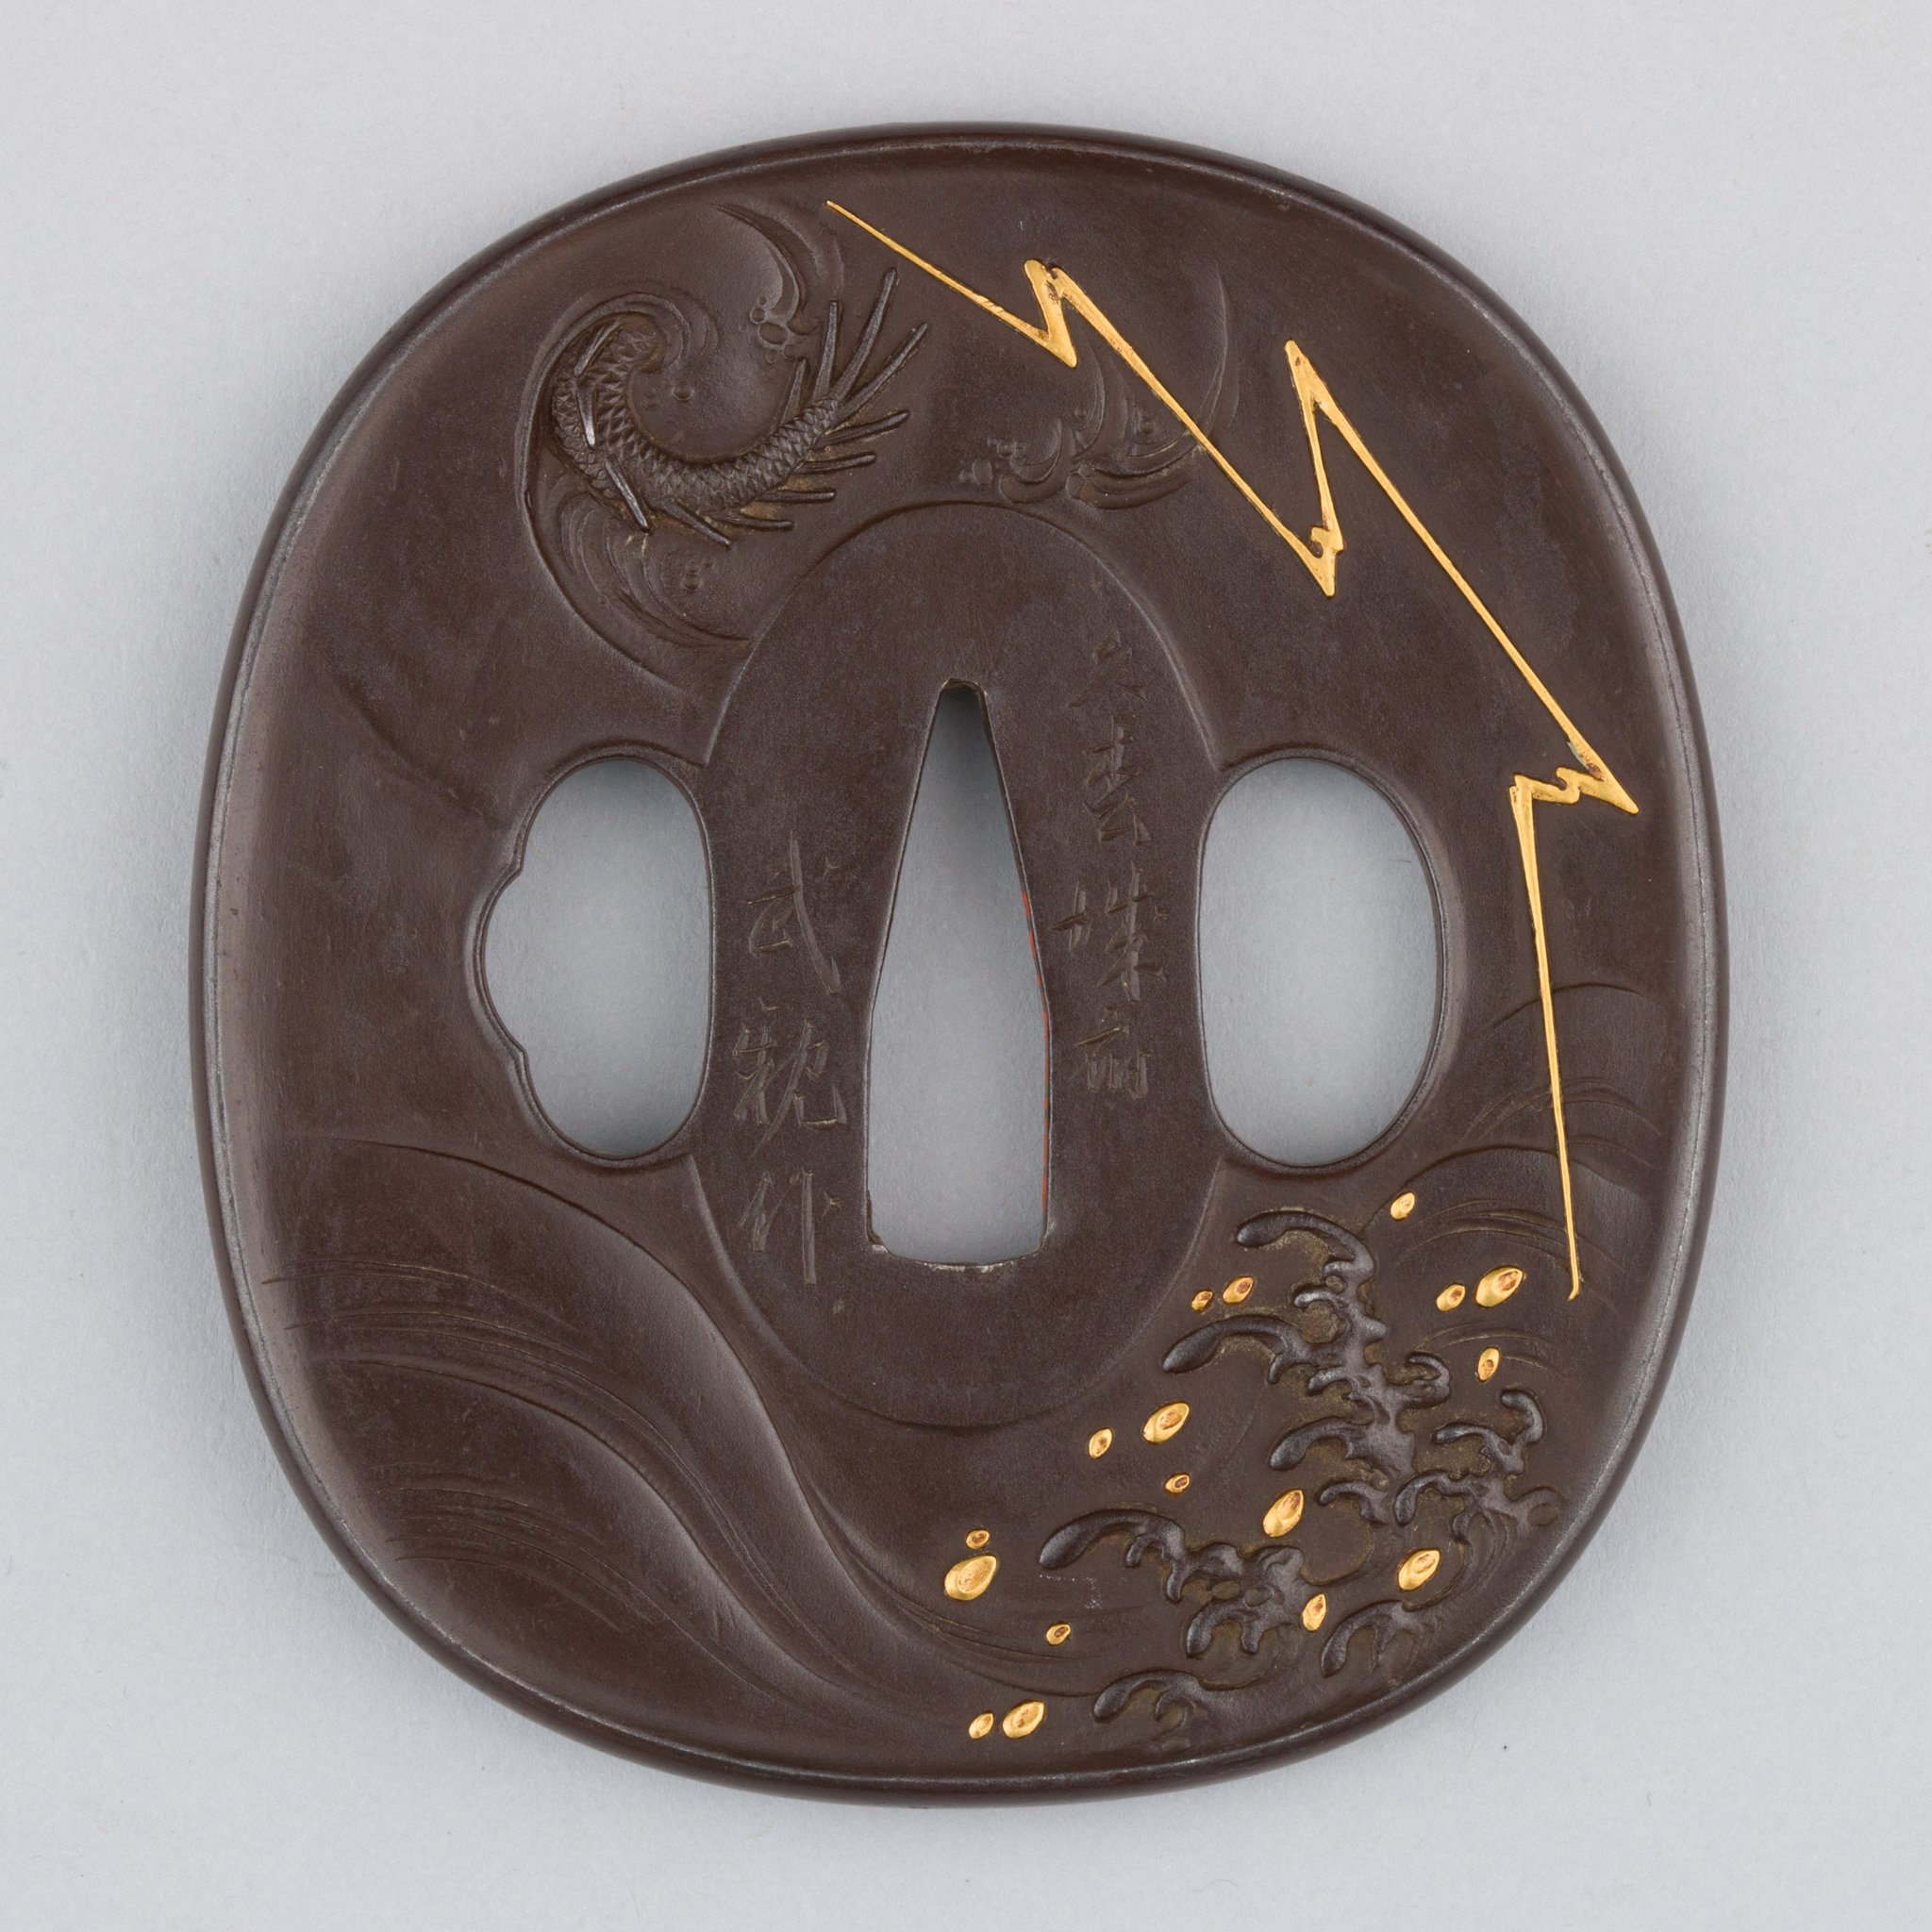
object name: sword guard tsuba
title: Sword Guard (Tsuba)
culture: japanese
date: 1810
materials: copper, gold, iron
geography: japan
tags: dragons